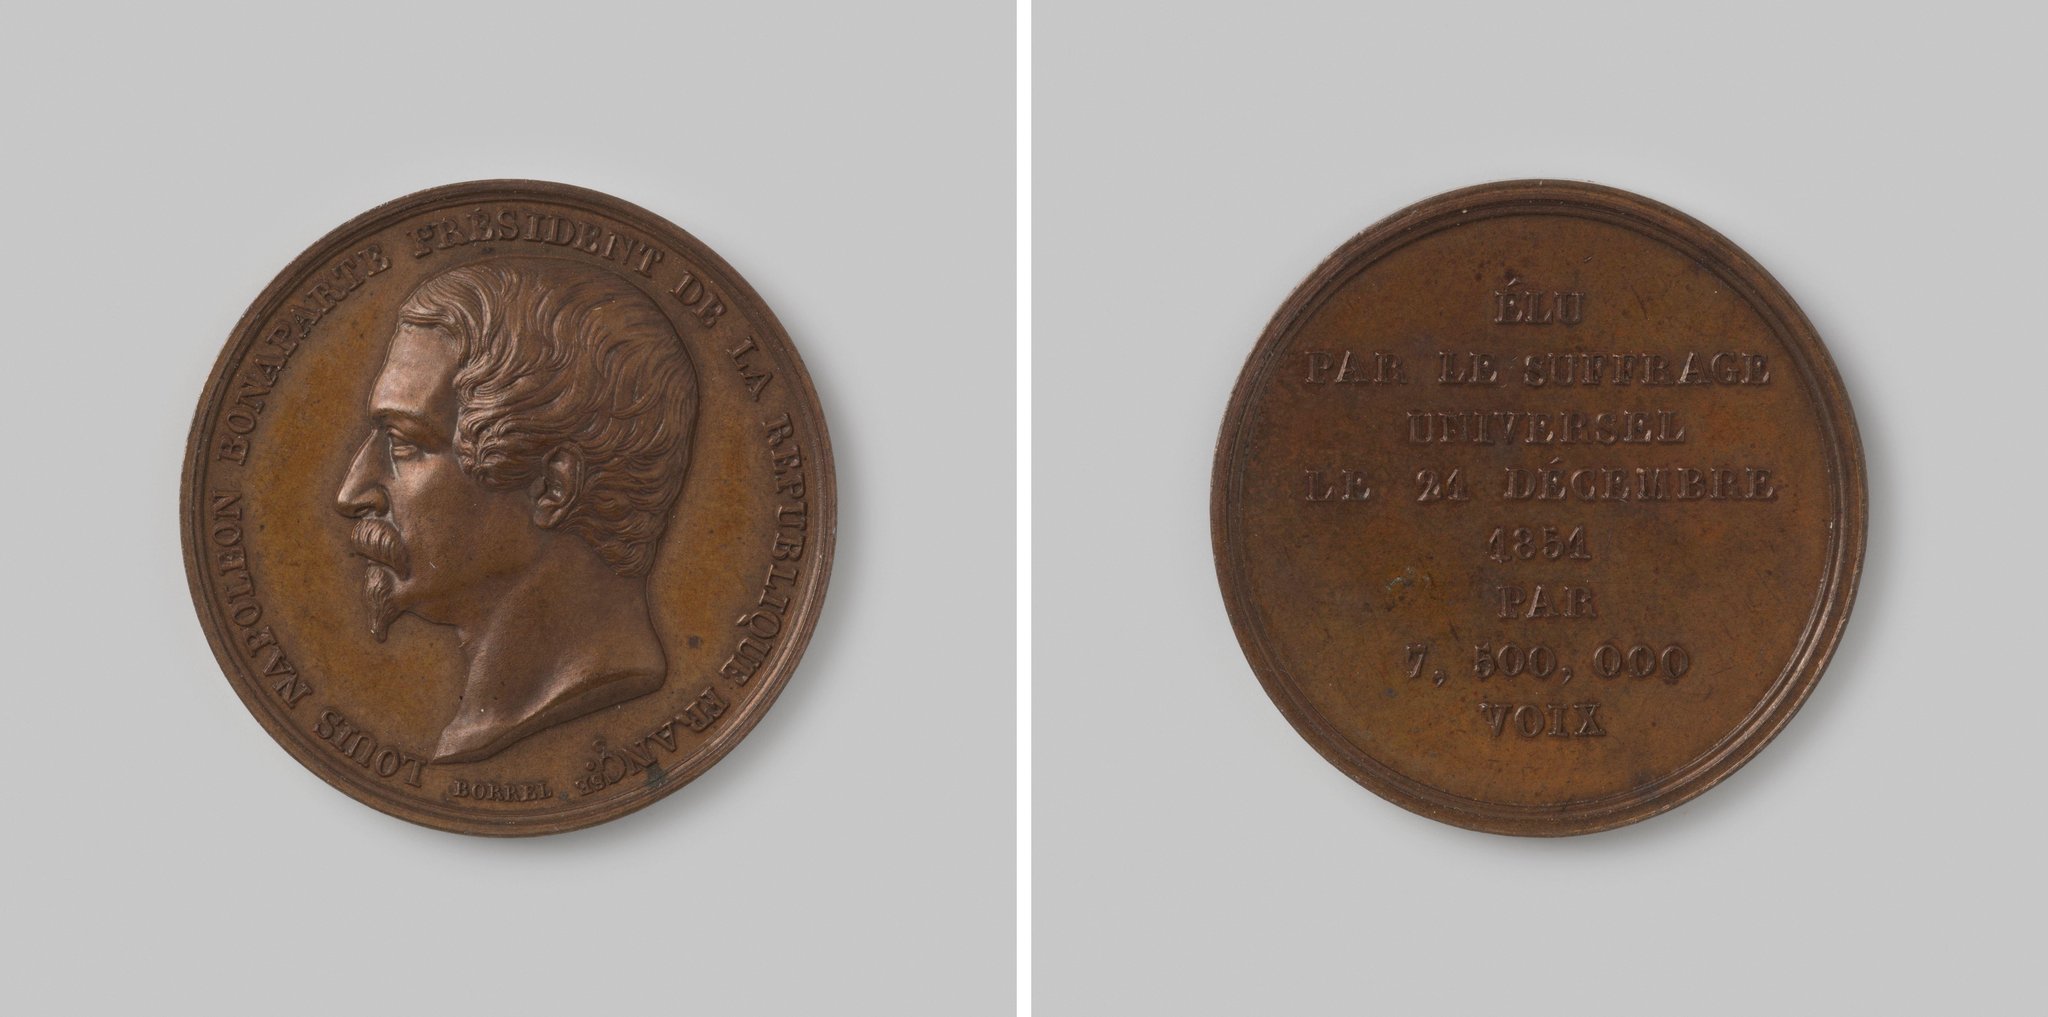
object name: history medal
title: Verkiezing van president Louis Napoleon Bonaparte tot Keizer 1851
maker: borrel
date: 1851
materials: copper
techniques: striking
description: Bronzen penning, op de voorzijde het portret van Bonaparte naar links met omschrift, op de keerzijde acht regels tekst.